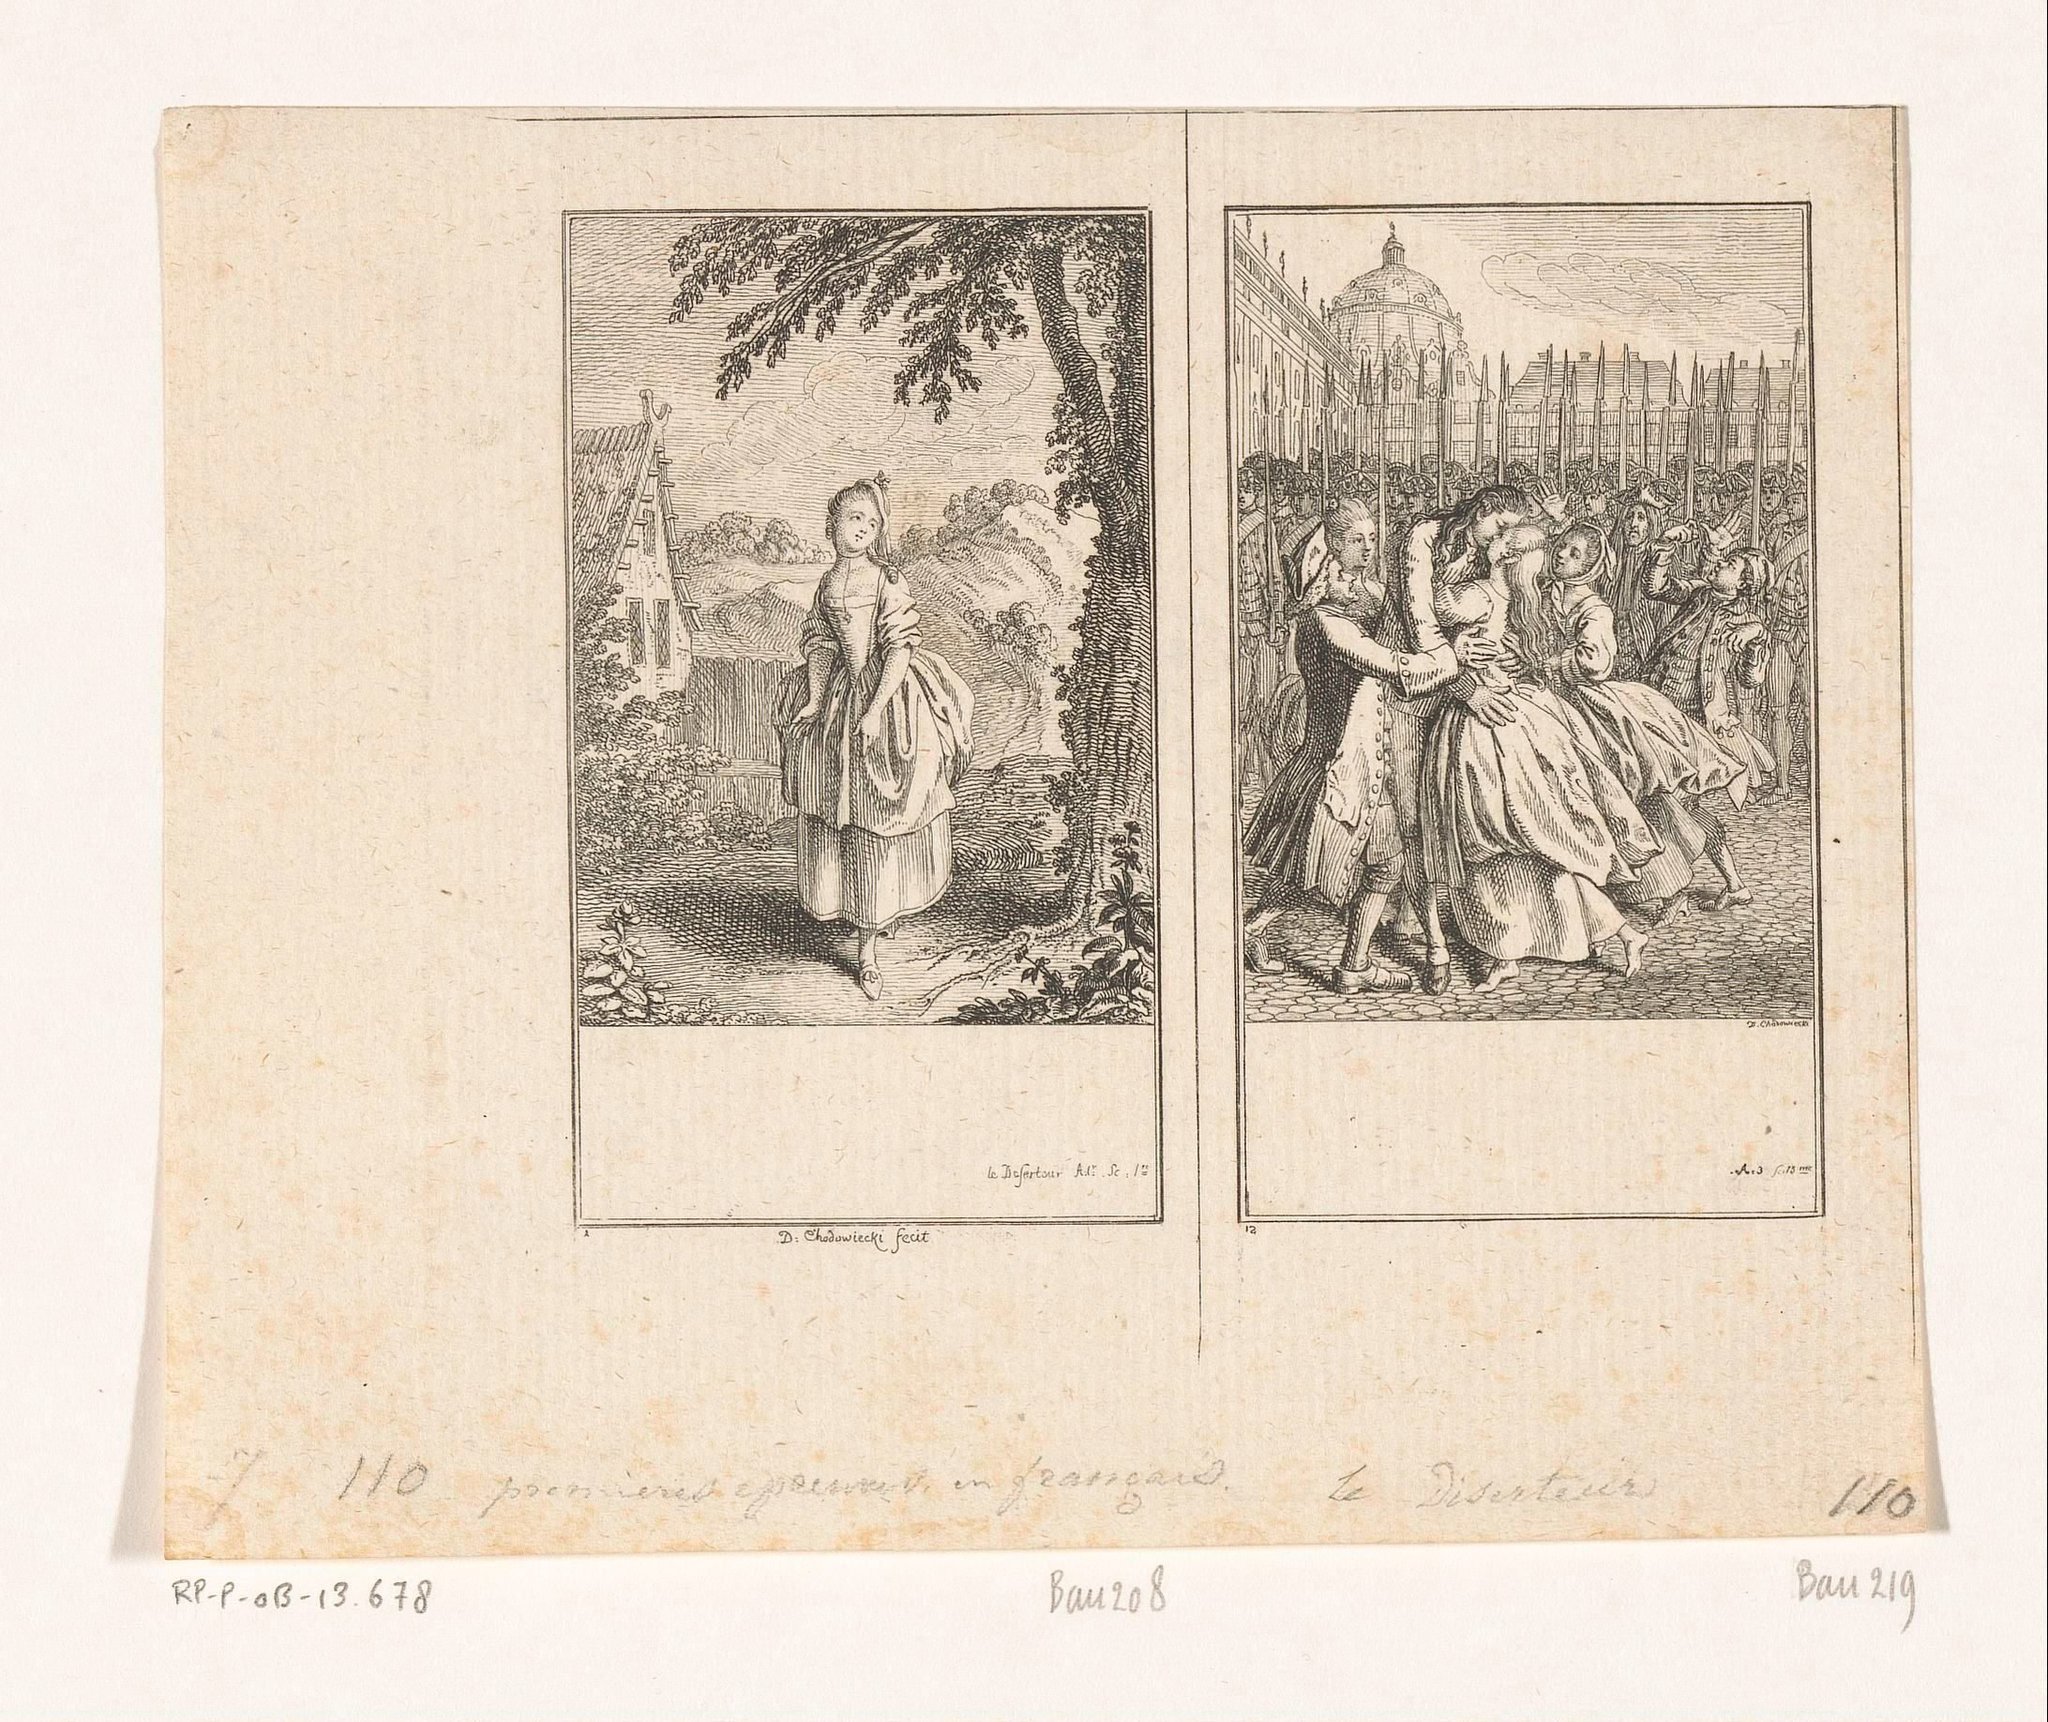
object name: print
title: Twee scènes uit de Deserteur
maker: daniel nikolaus chodowiecki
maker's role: draughtsman, print maker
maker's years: 1726-1801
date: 1774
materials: paper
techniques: etching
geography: berlin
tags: paris, literature, private soldier, (lovers) embracing each other, 'symplegma', village square, place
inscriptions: collector's mark: Lugt 2228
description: Eerste en twaalfde scène uit een serie van twaalf scènes die de opéra comique 'Le déserteur' door Michel-Jean Sedaine illustreren. De scènes werden op een plaat geëtst. De tweede staat van deze serie werd ook gebruikt in: 'Berliner genealogischen Calender auf das Jahr 1775'.